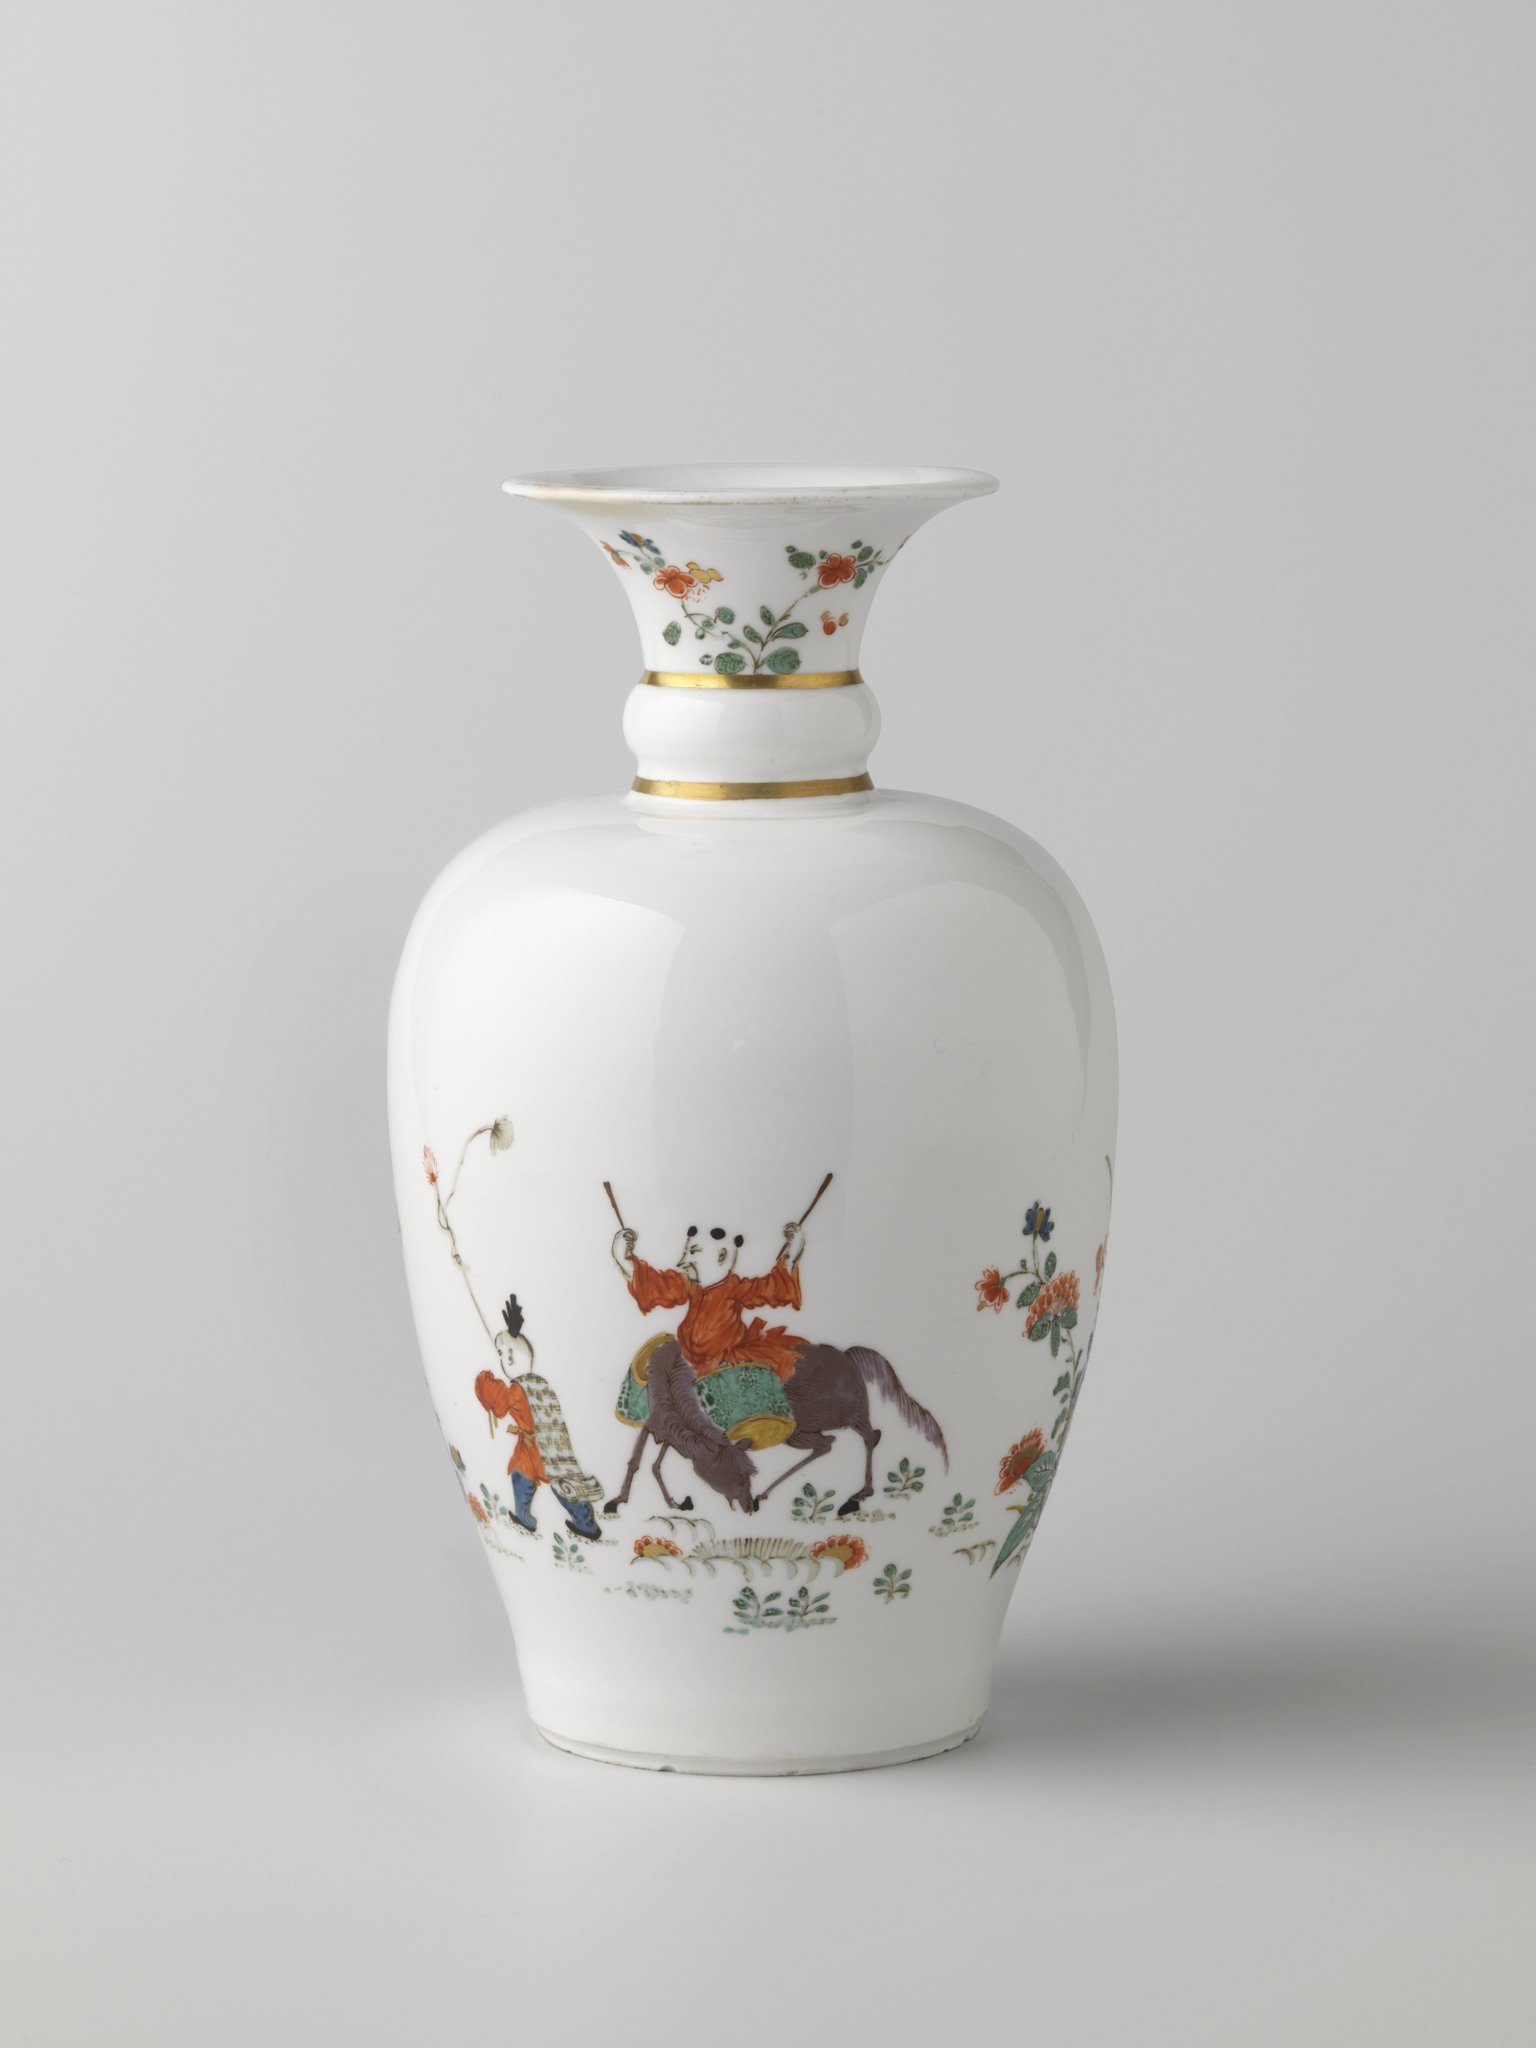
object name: decoratief object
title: Vaas, veelkleurig beschilderd met chinoiserieën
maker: johann elias grund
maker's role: porseleinmodelleur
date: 1730-1735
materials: porcelain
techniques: painted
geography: meissen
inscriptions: factory mark: ‘AR’, mold mark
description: Plate. Porcelain. Meissen, c. 1735. Two vases. Porcelain. Meissen, c. 1730 - 1735.